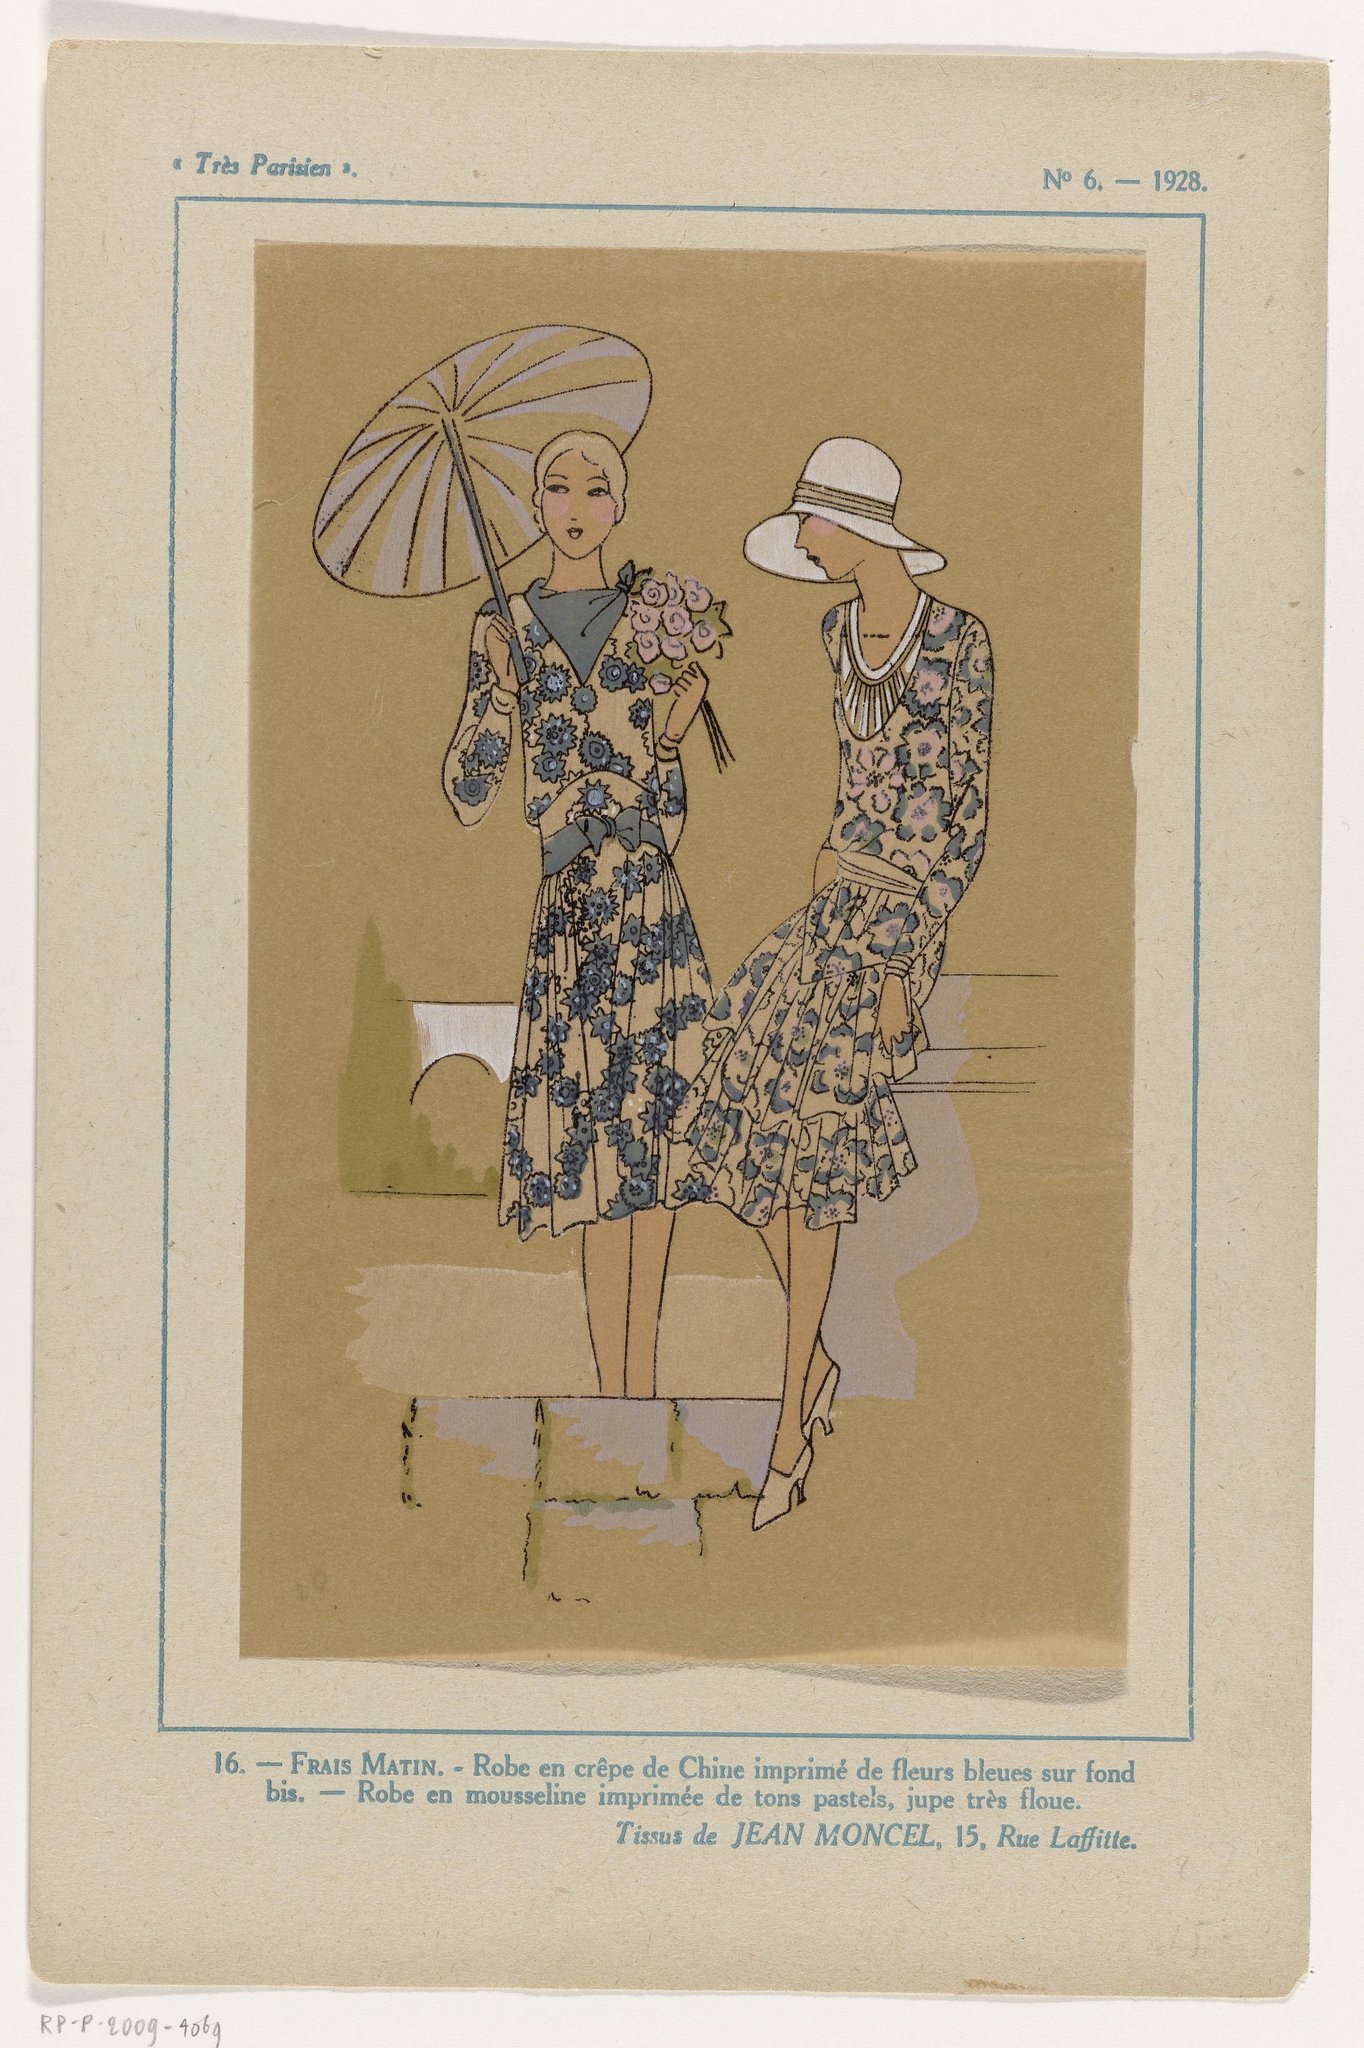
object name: fashion print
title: Très Parisien, 1928, No. 6 : 16.- FRAIS MATIN.- Robe en crêp (...)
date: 1928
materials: paper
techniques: hand coloring, letterpress printing, lithography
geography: paris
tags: cut flowers; nosegay, bunch of flowers, neck-gear ~ clothing (neckerchief) (+ women's clothes), fashion plates, head-gear: hat (+ women's clothes), dress, gown (+ women's clothes), parasol, sunshade (+ women's clothes)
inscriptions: caption: ‘16. - FRAIS MATIN. - Robe en crêpe de Chine imprimé de fleurs bleues sur fond bis. - Robe en mouseline imprimée de tons pastels, jupe très floue. / Tissus de JEAN MONCEL, 15, Rue Laffitte.’, title: ‘"Très Parisien". / No 6. - 1928’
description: Jurk van 'crêpe de Chine' bedrukt met bloemmotief in blauw. Jurk van bedrukte mousseline in pasteltinten. Stoffen van Jean Moncel. Accessoires: parasol, hoed met brede rand, geknoopte halsdoek, pumps. Prent uit het modetijdschrift Très Parisien (1920-1936).